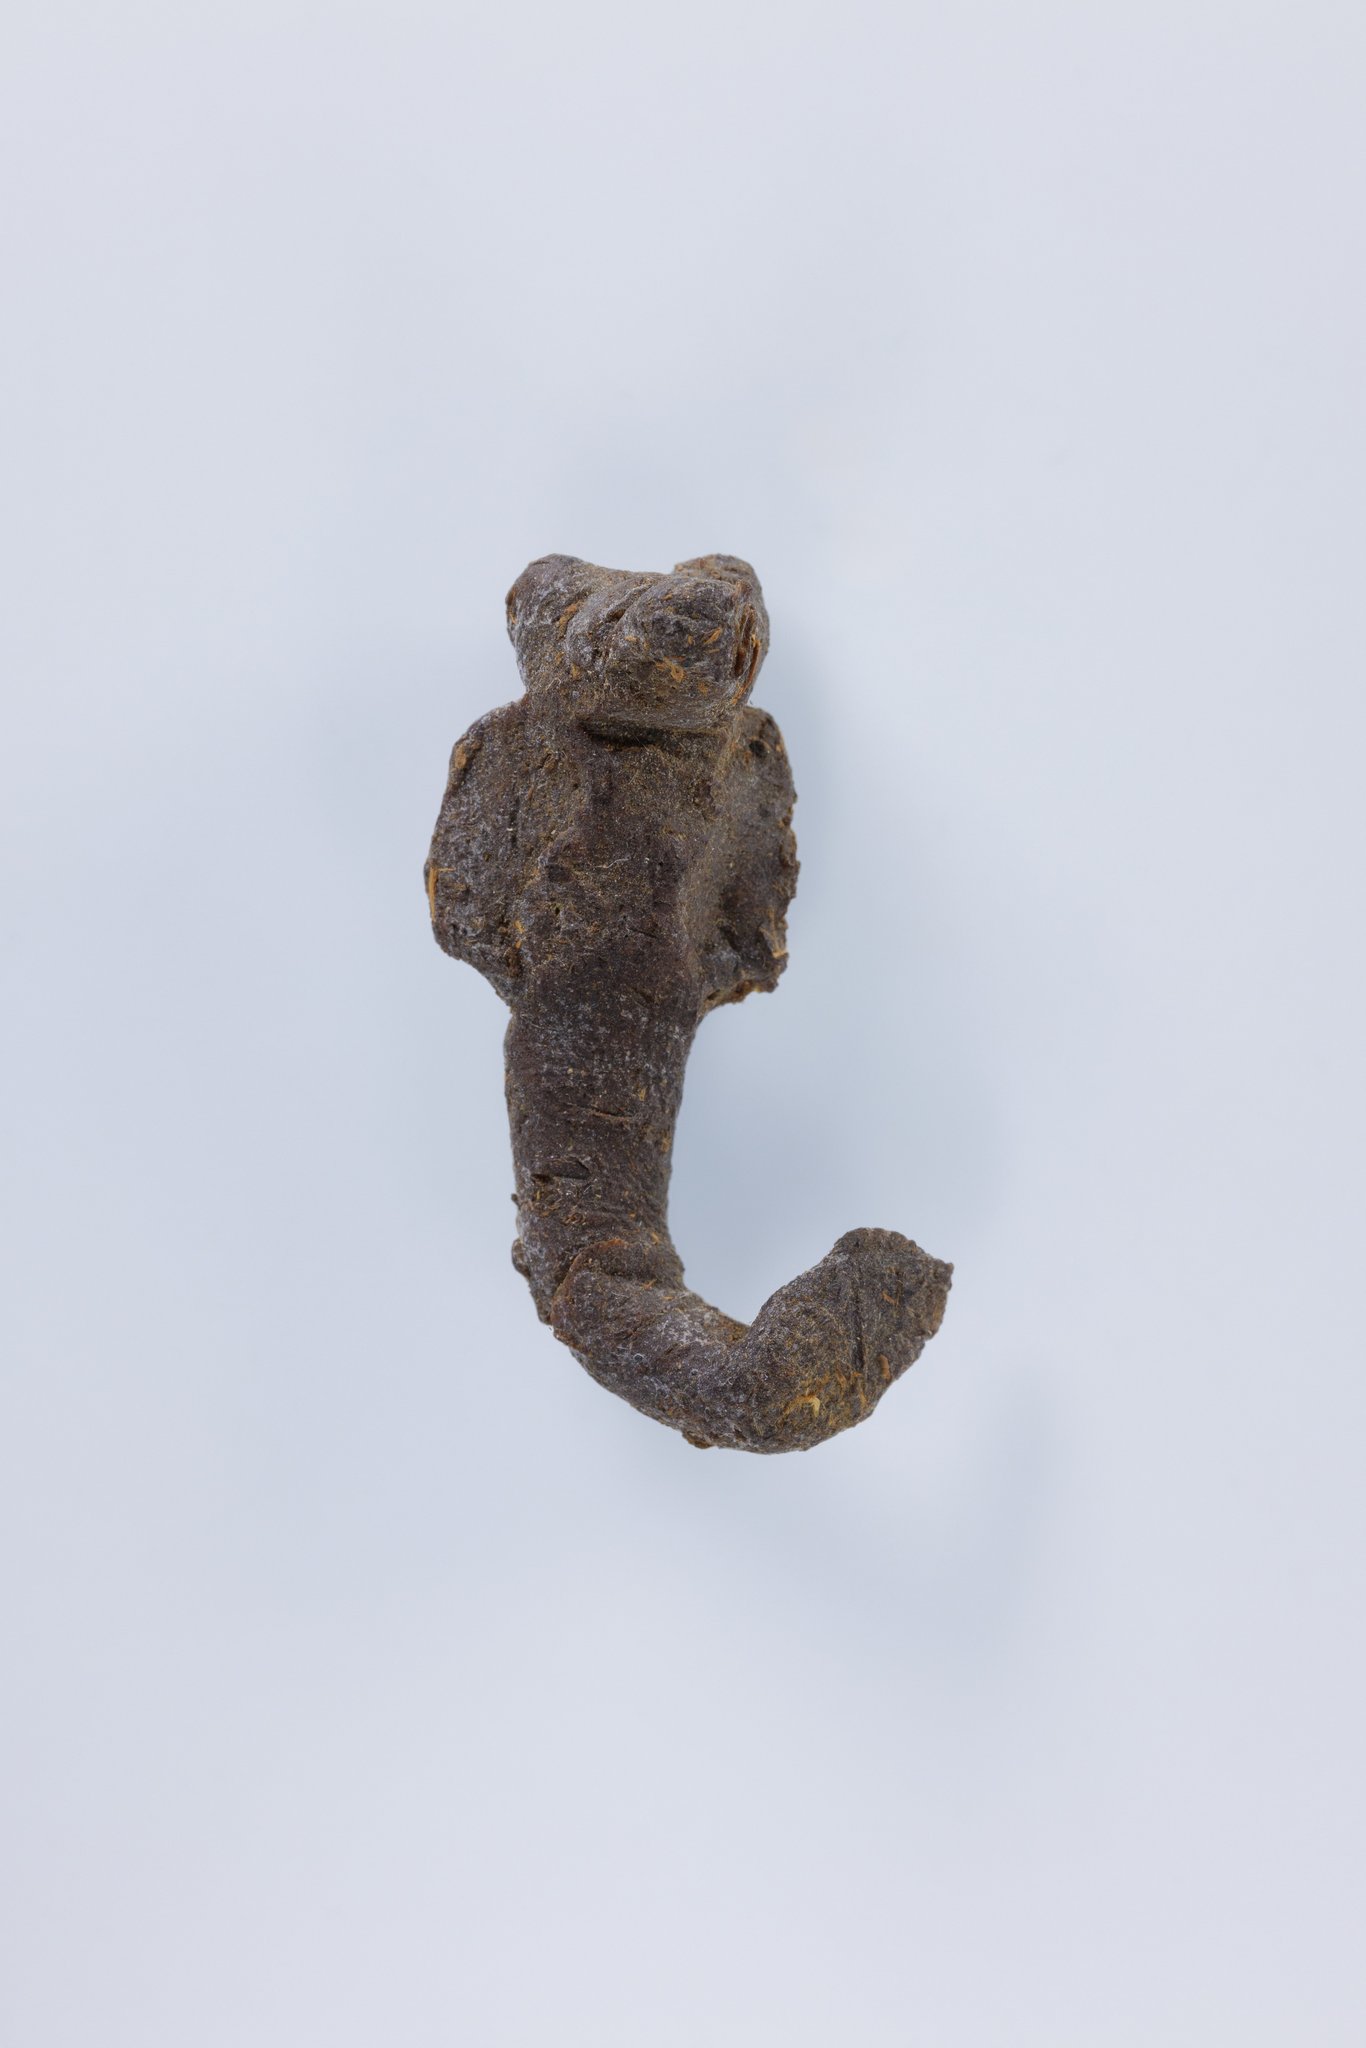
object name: four son of horus, hapy, baboon headed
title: Viscera figure with baboon head (Hapy)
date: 1000-945 BCE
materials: wax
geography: egypt